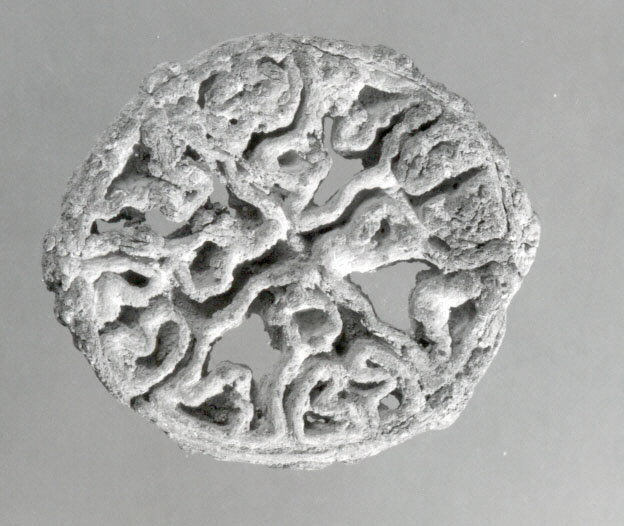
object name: stamp seal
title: Compartmented stamp seal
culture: bactria-margiana archaeological complex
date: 2333-1668 BCE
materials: copper alloy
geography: bactria-margiana